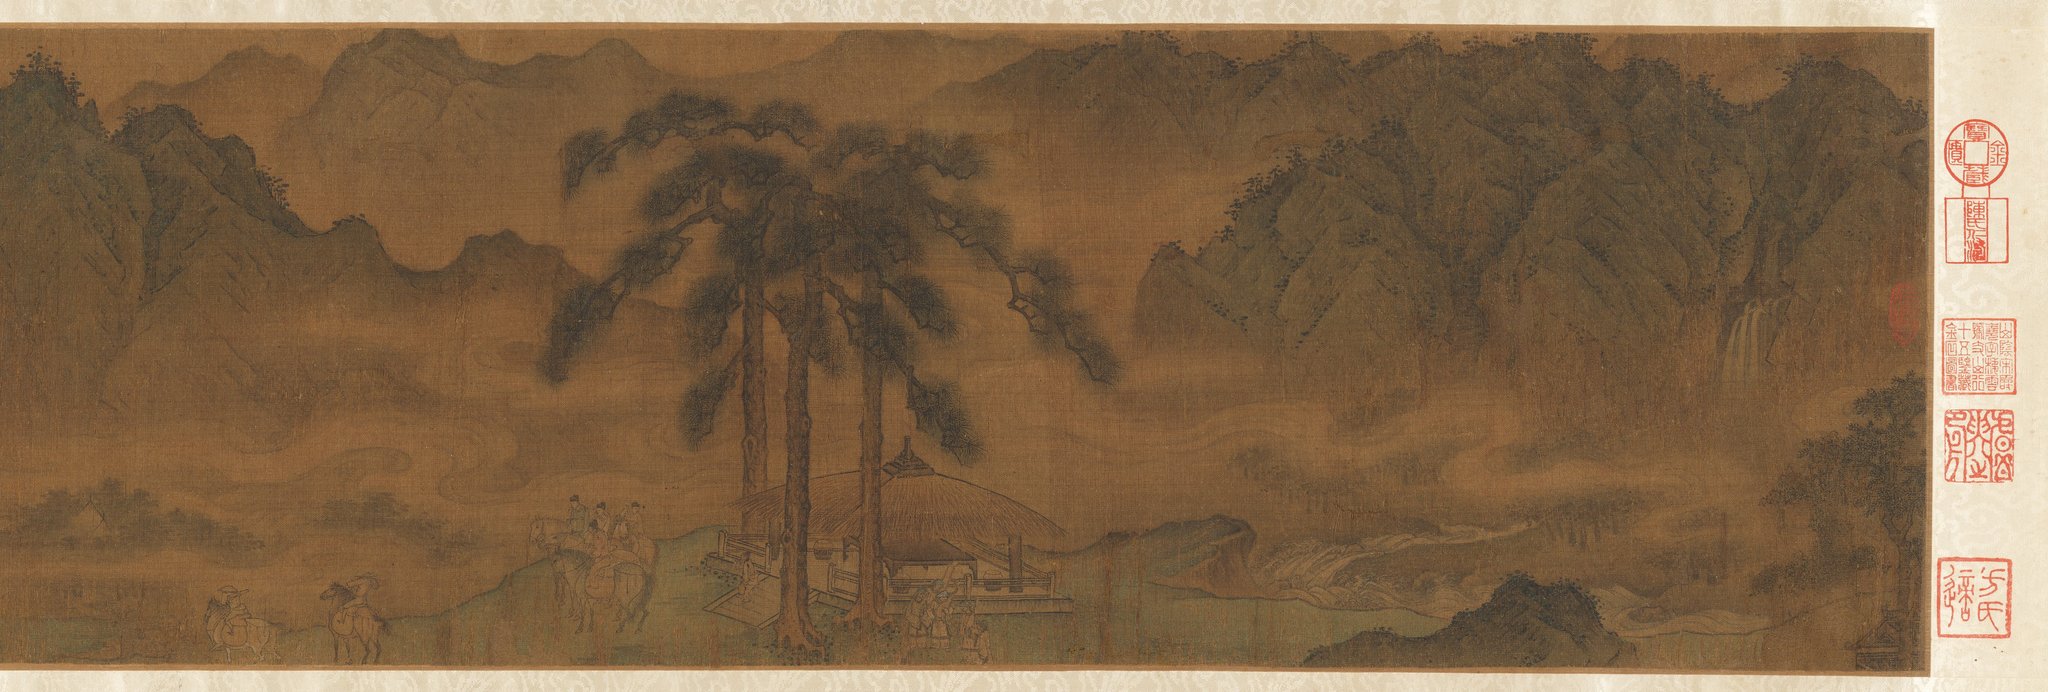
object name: handscroll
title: A Diplomatic Mission to the Jin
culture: chinese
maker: yang bangji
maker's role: artist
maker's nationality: chinese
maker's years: 1100-1191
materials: ink, silk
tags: mountains,landscapes